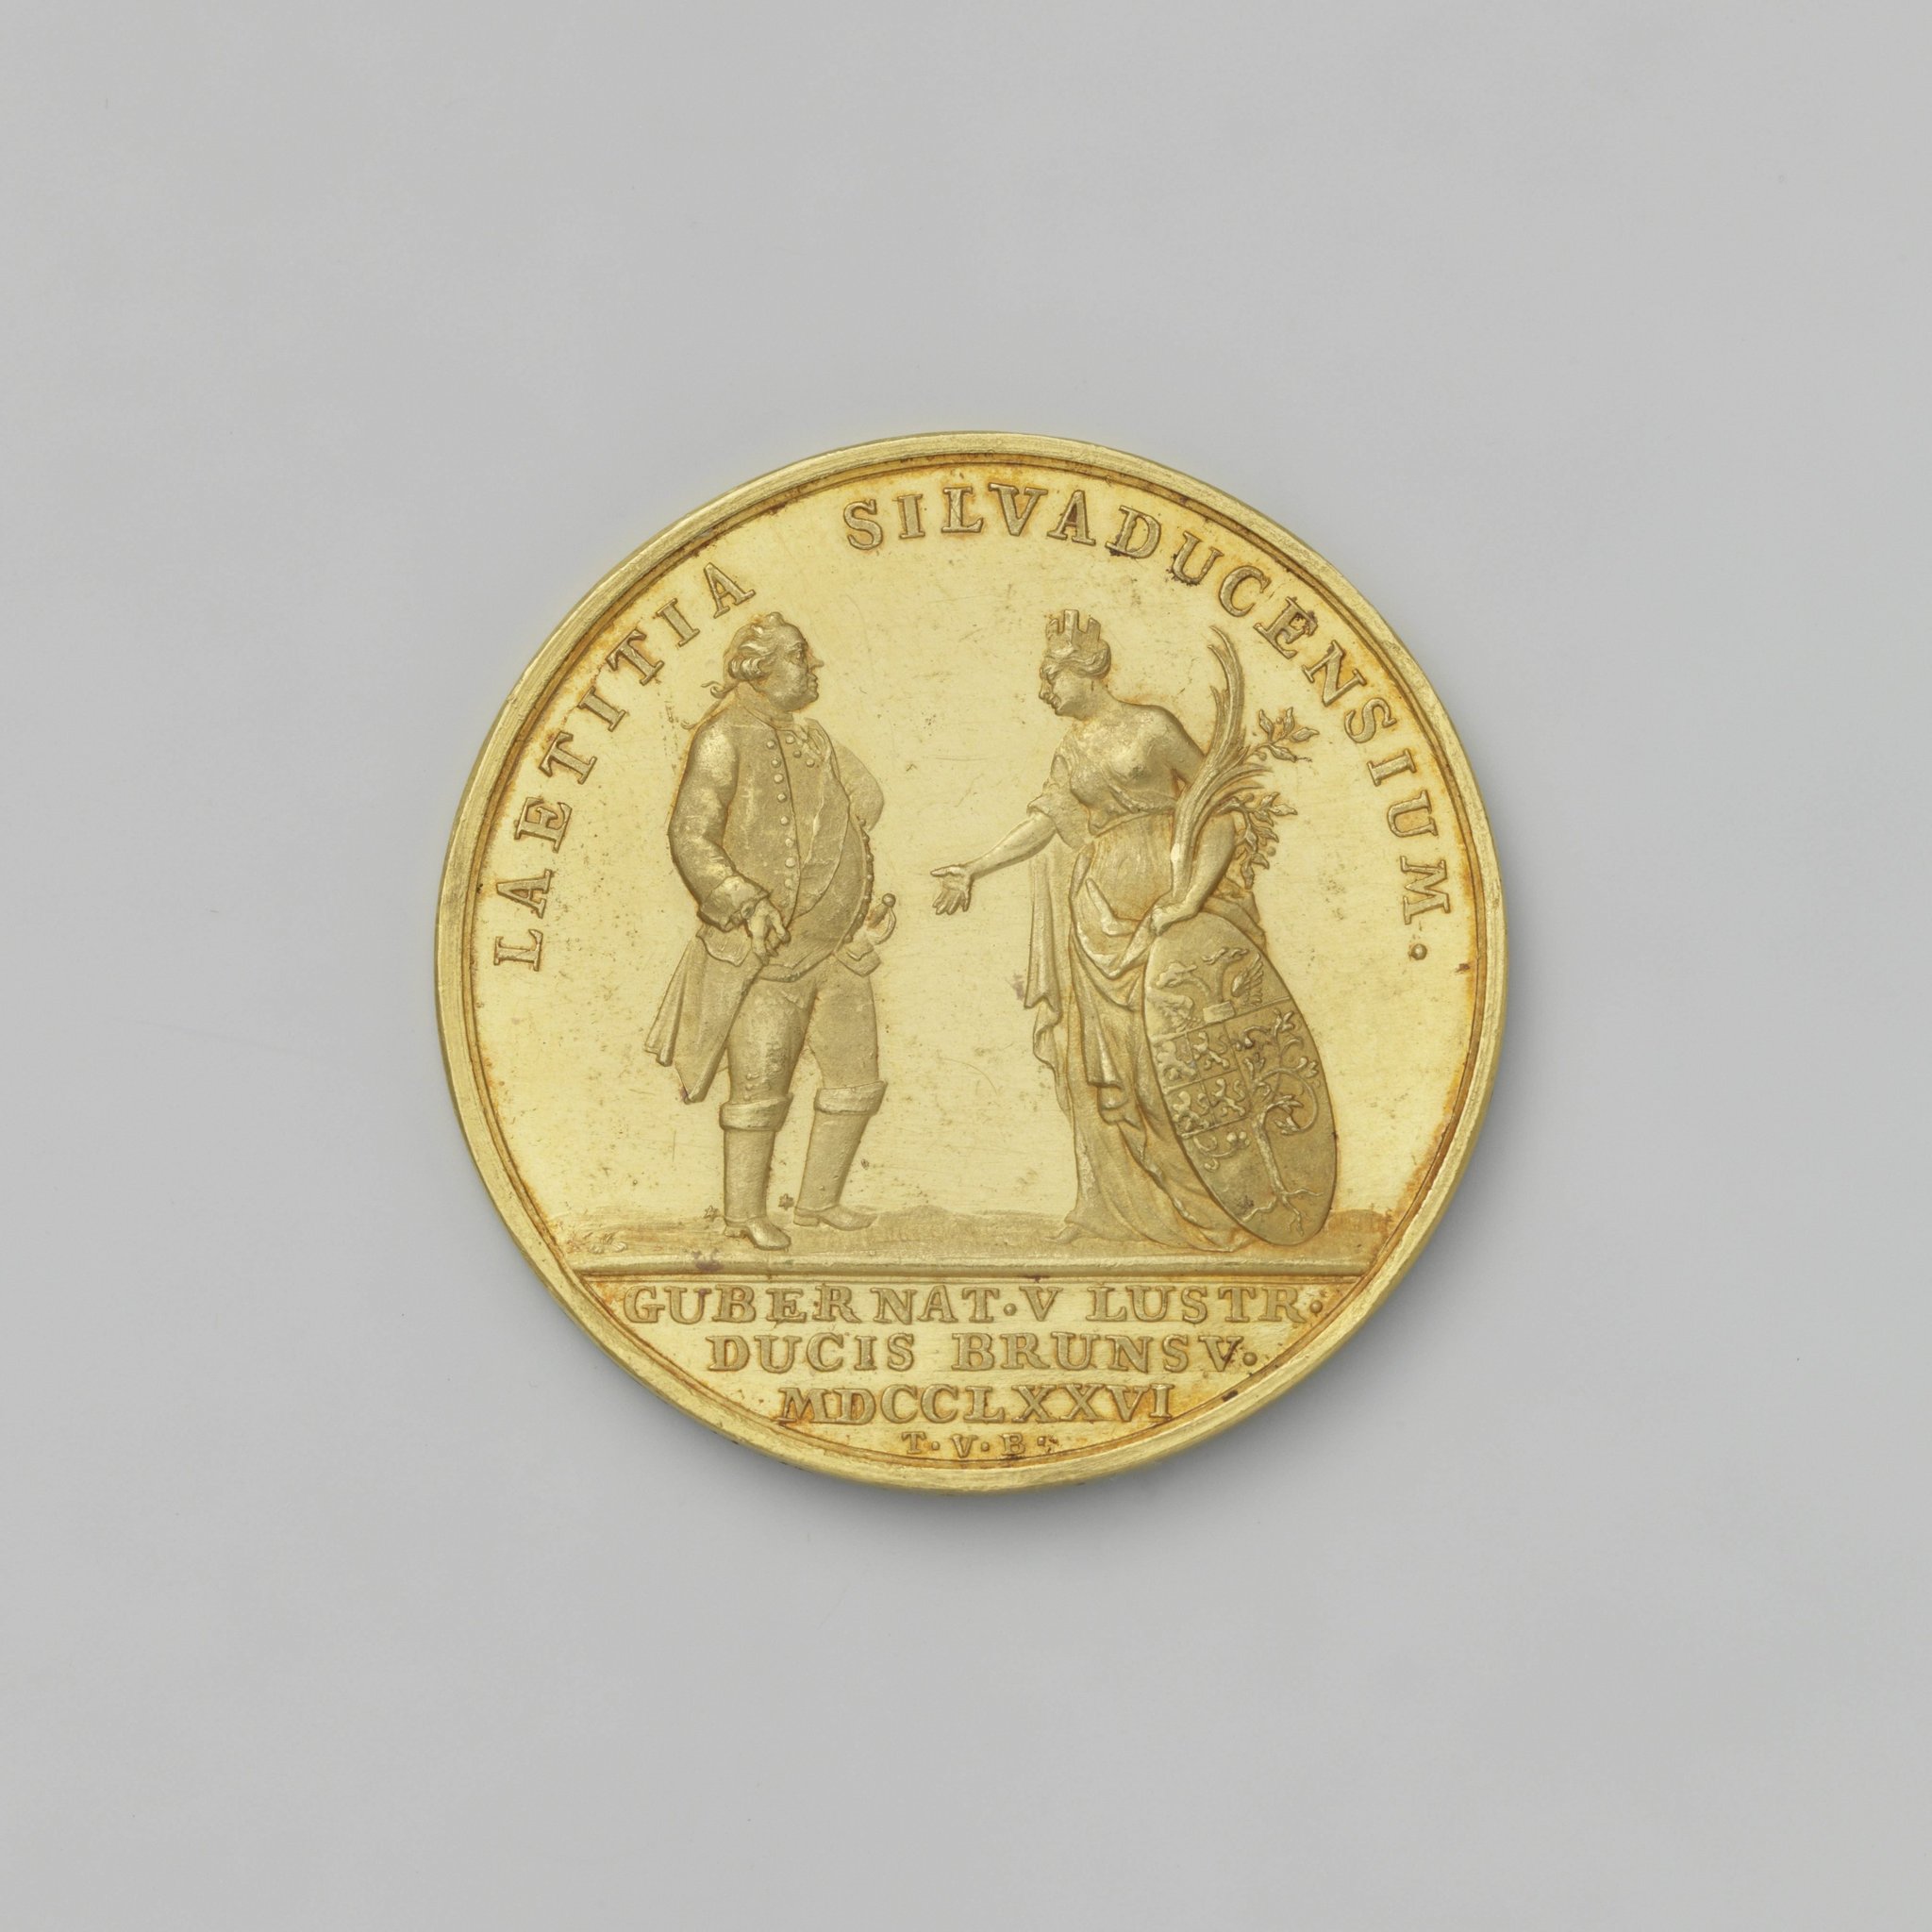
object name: council medal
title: 's-Hertogenbosch, vroedschapspenning op Lodewijk Willem Ernst, hertog van Brunswijk-Wolfenbuttel, sinds 25 jaar gouverneur van 's-Hertogenbosch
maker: theodorus victor van berckel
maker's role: mintmaster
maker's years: 1739-1808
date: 1776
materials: gold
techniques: striking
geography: den bosch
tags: ludwig ernst von braunschweig-wolfenbüttel, den bosch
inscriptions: inscription: ‘GEBURNET DIU’, inscription: ‘S.C.’, edge inscription: ‘LAETITIA SILVADUGENSIUM’, inscription: ‘GUBERNAT V LUSTR. DUCIS BRUNV. MDCCLXXVI’, inscription: ‘DECUS ET SECURITAS’